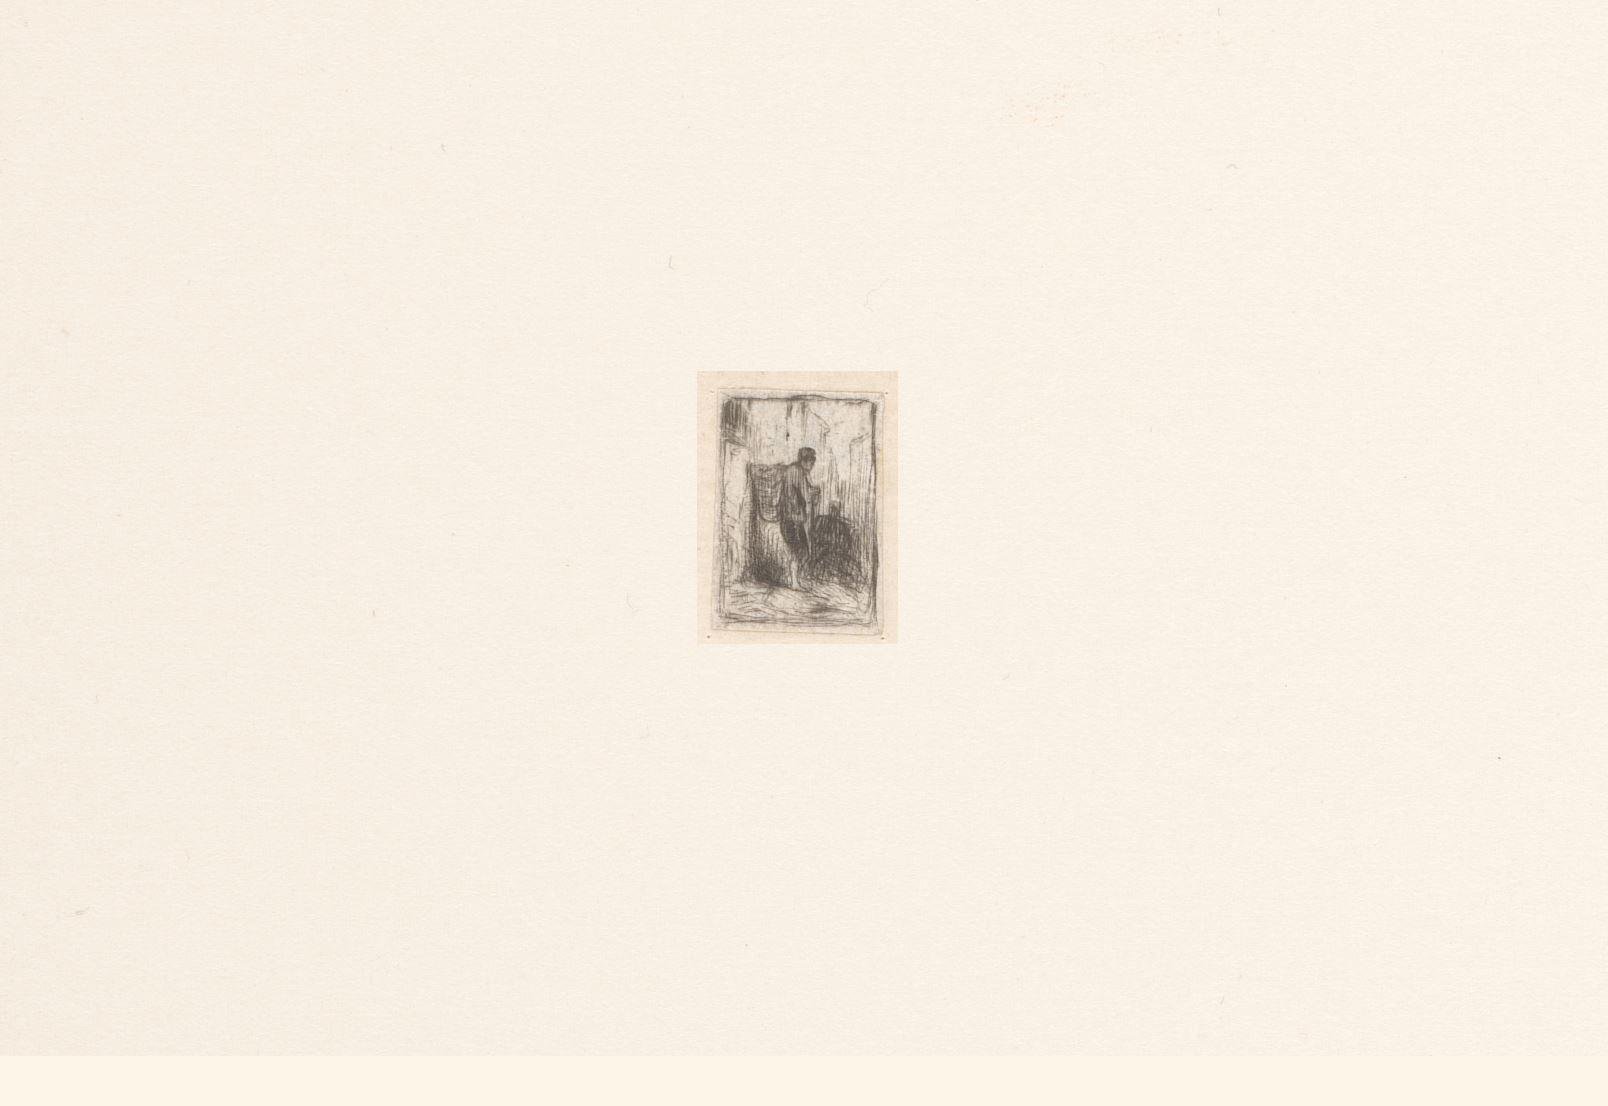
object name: print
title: Voddenraper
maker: charles emile jacque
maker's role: draughtsman, painter, print maker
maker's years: 1813-1894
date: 1843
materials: paper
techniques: drypoint, engraving, etching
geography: france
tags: street-trader